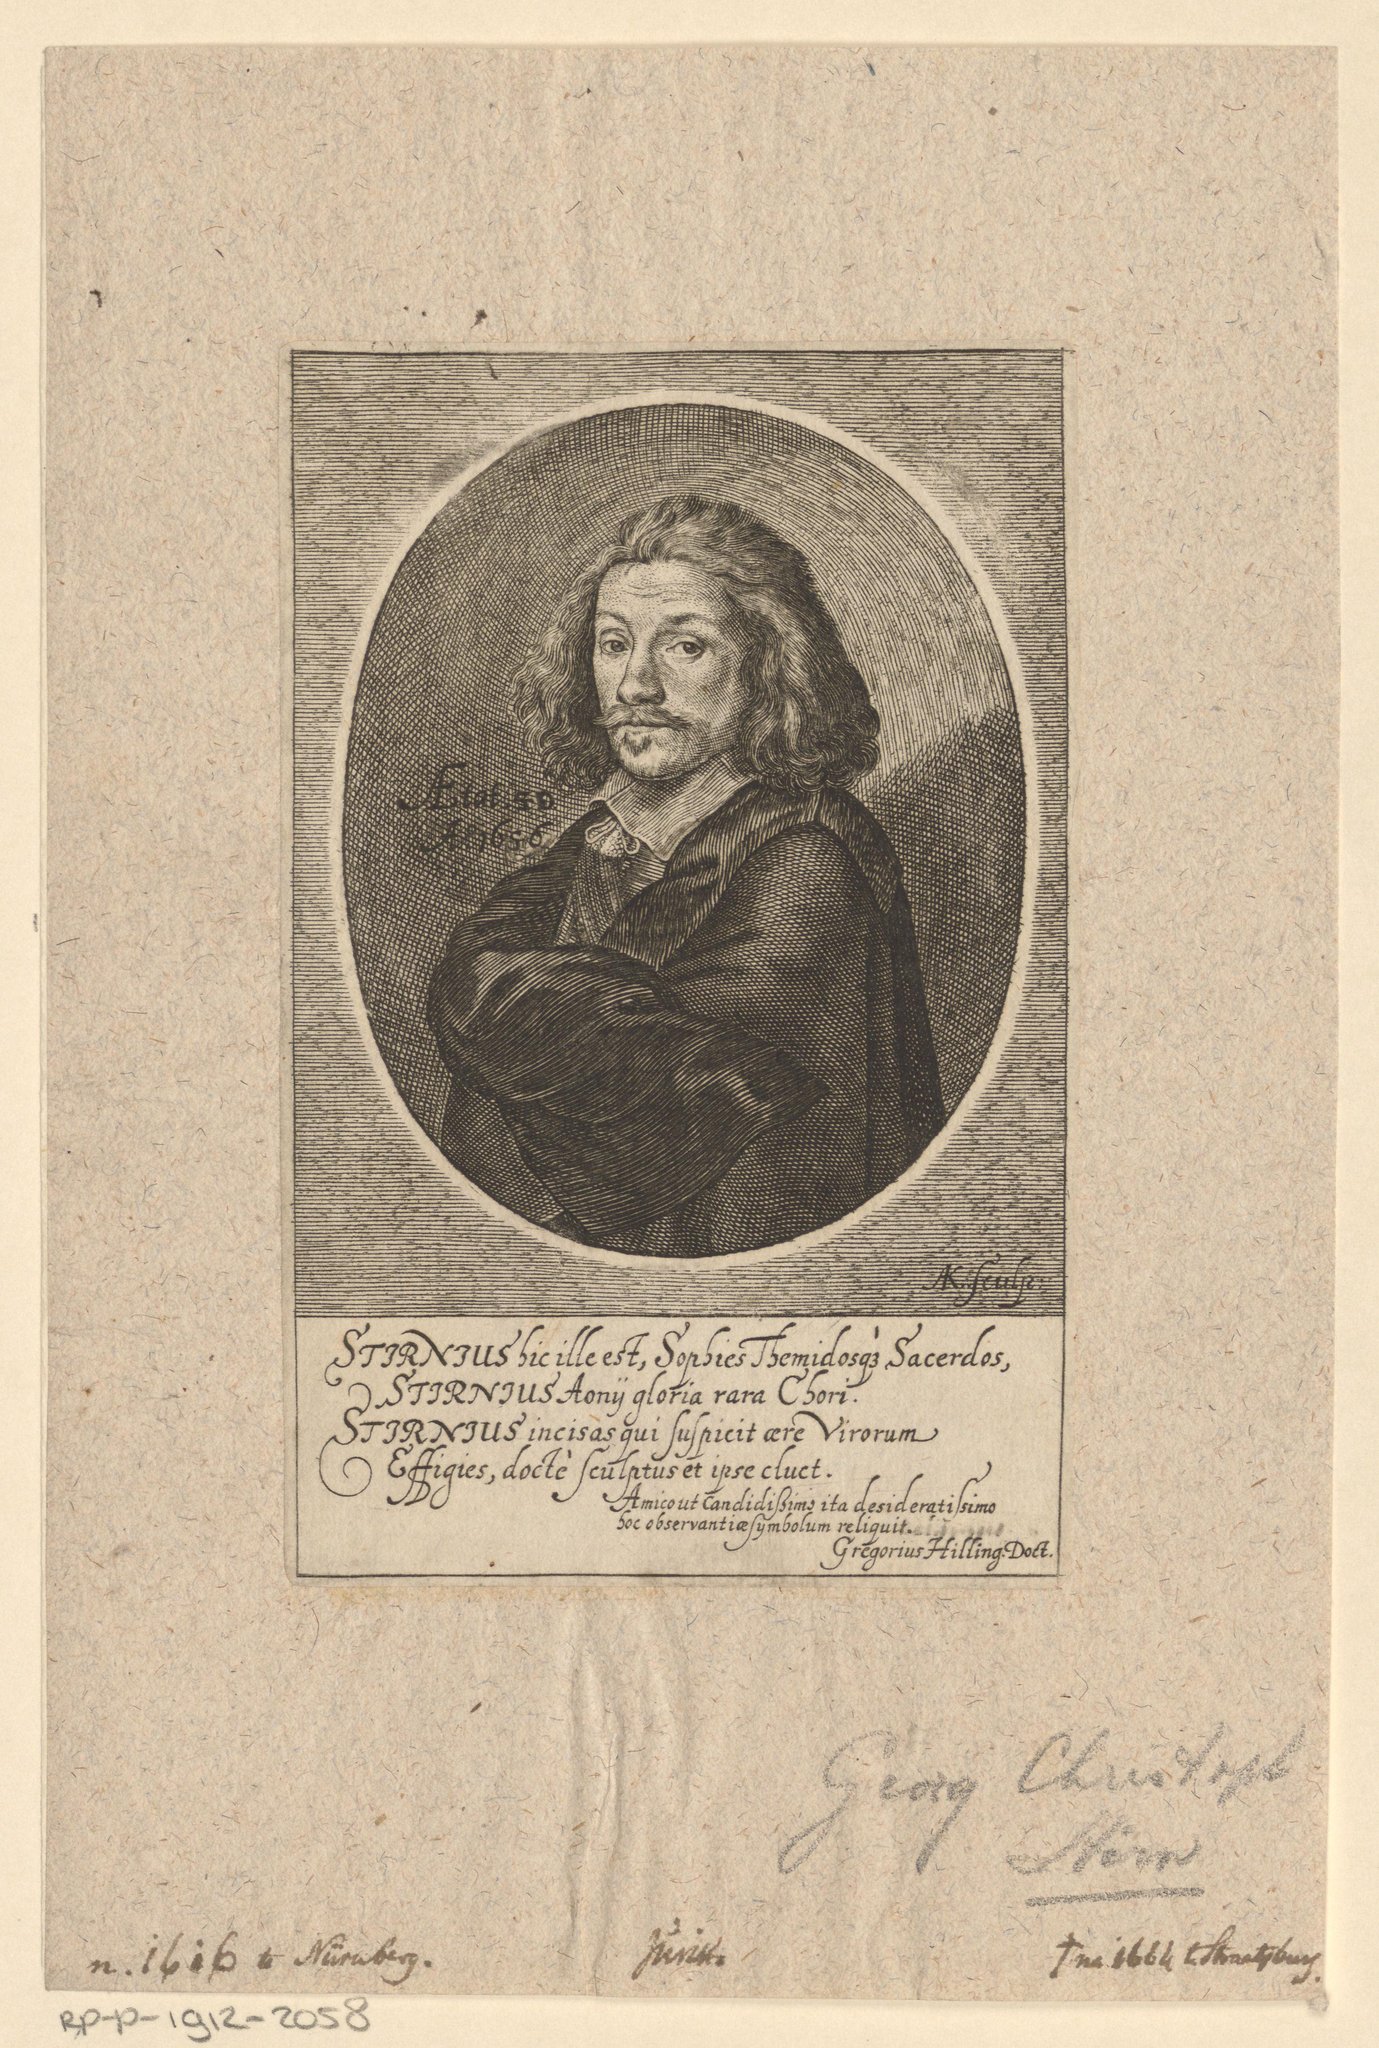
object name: print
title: Portret van Georg Christoph Stirn op 50-jarige leeftijd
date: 1649-1656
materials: paper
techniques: engraving, snipping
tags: georg christoph stirn, historical persons, portrait of a writer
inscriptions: collector's mark: Lugt 2228, inscription: ‘n. 1616 te Nürnberg / Jürist. / + na 1664 te Straatsburg’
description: Met zesregelig onderschrift in het Latijn.